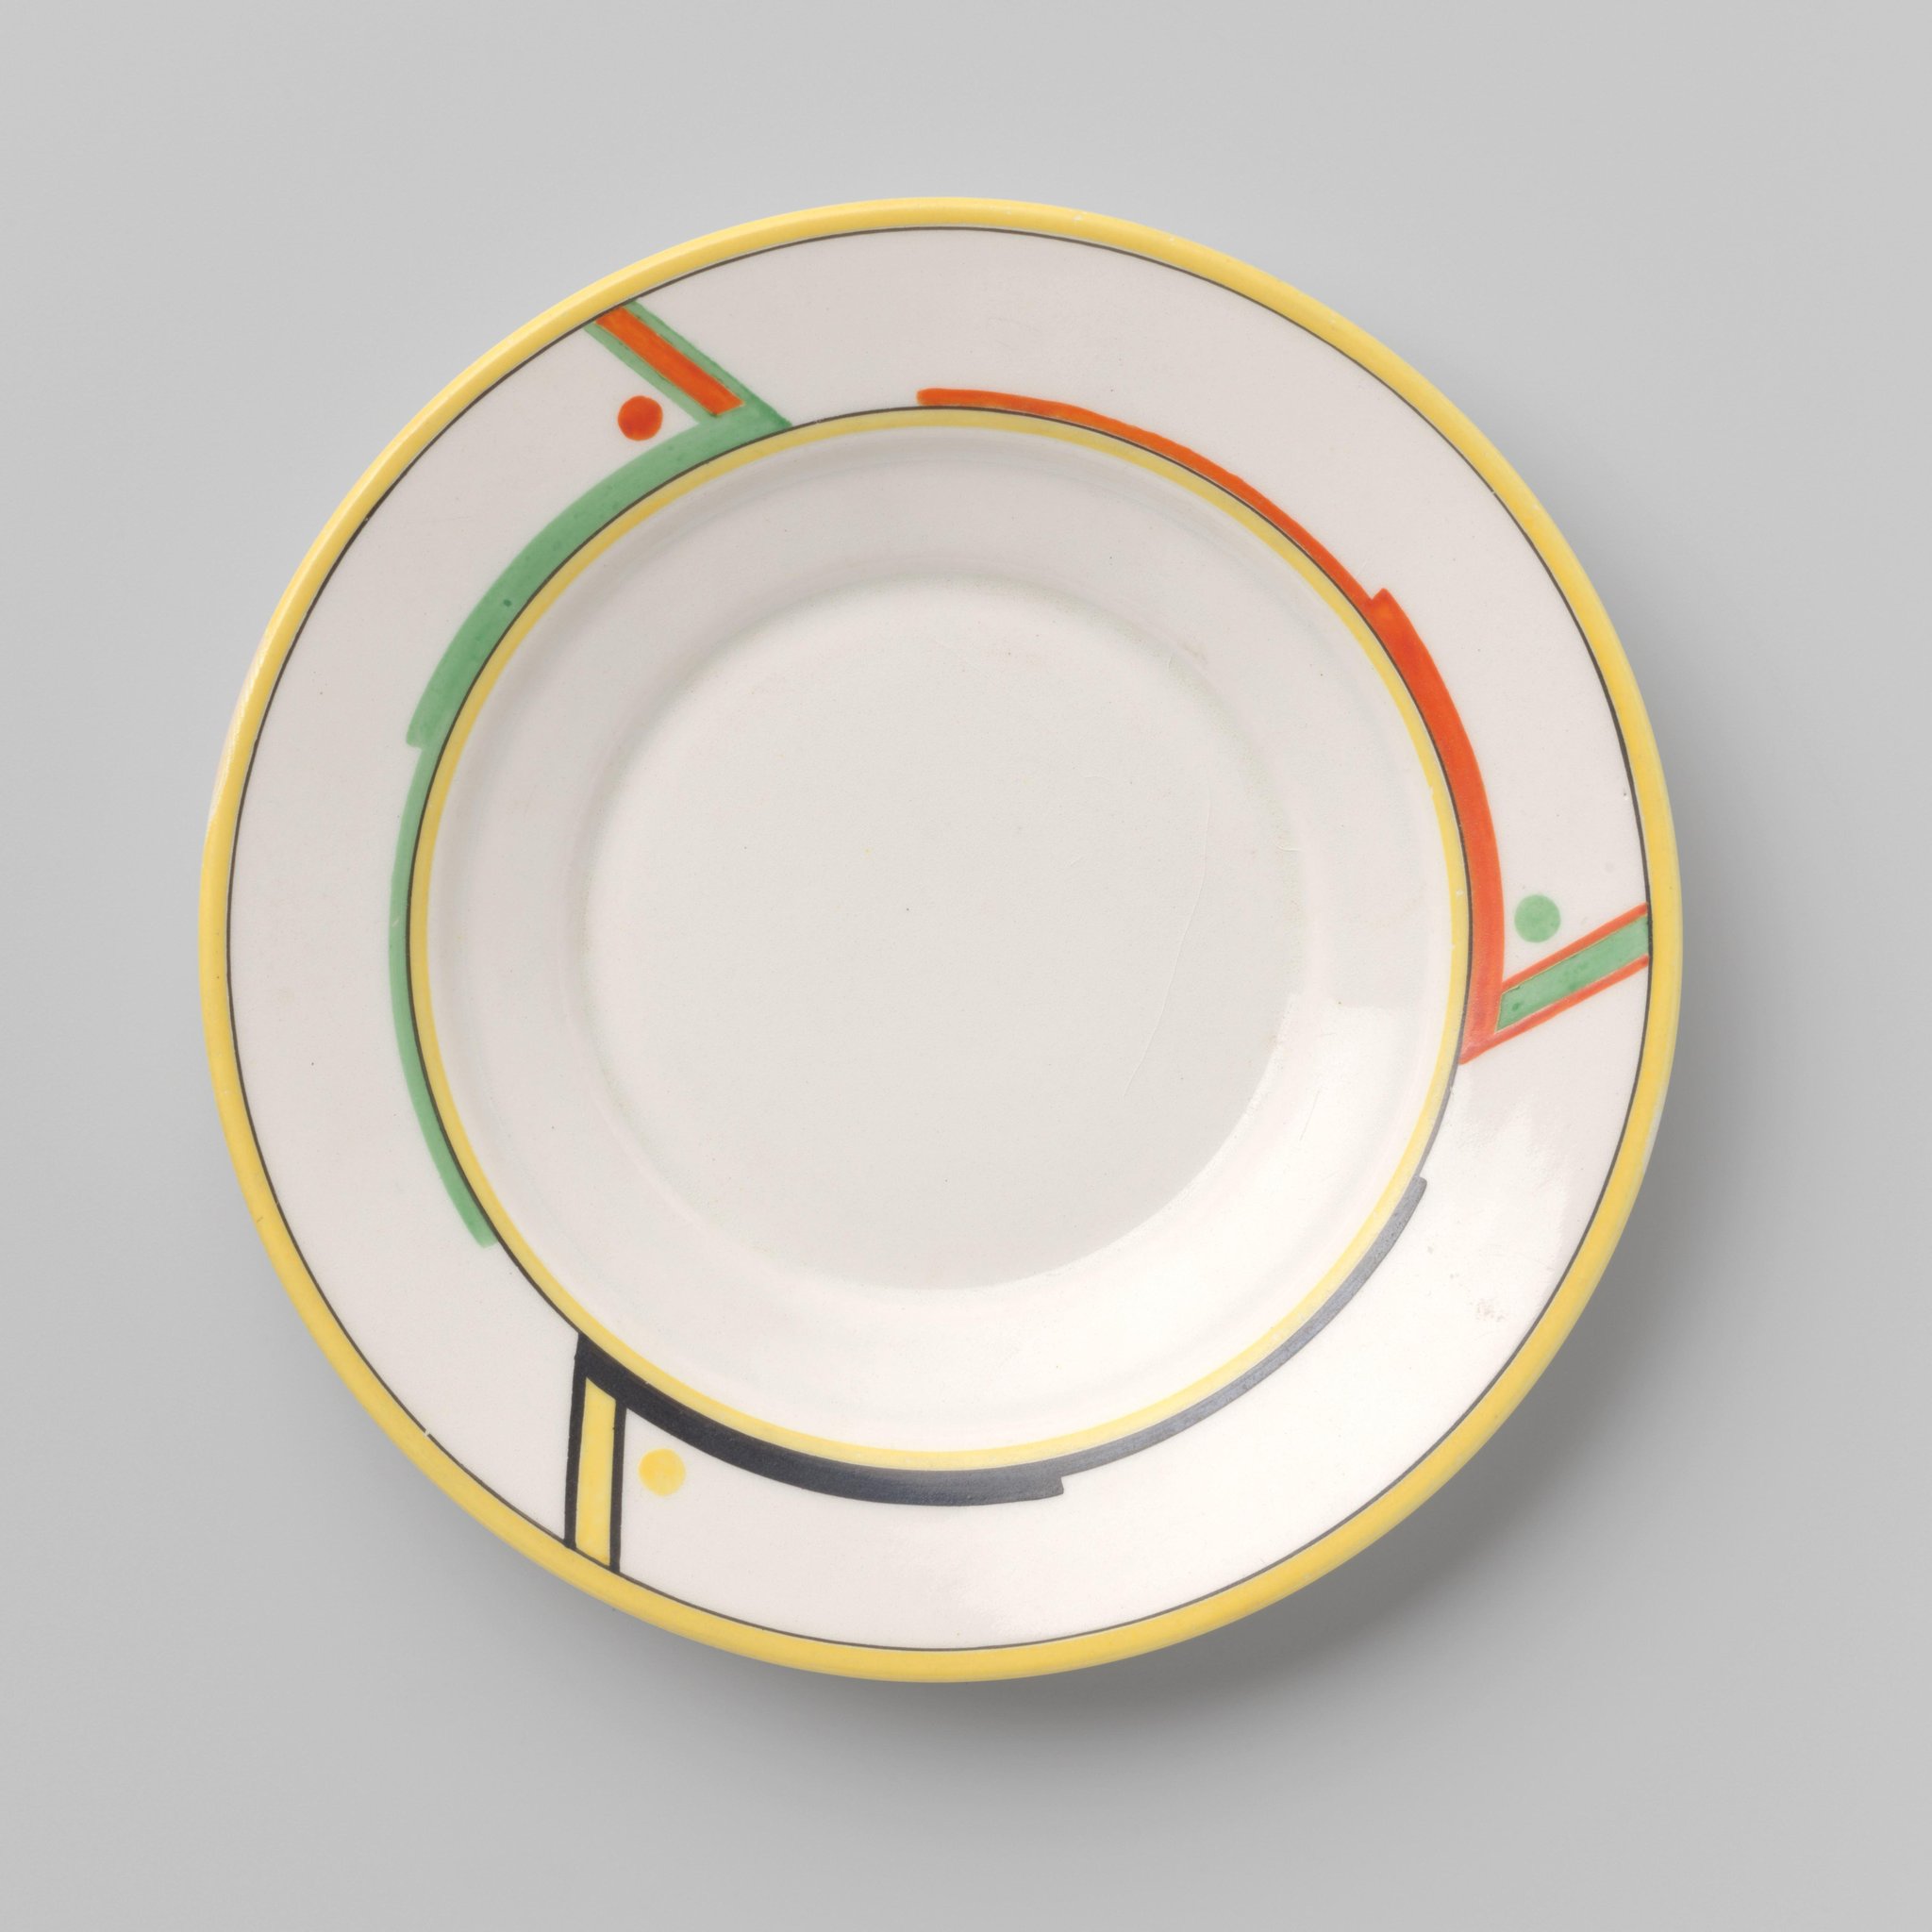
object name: platter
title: Schotel met constructivistisch ornament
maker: chris van der hoef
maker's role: ceramicist, draughtsman, sculptor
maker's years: 1875-1933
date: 1928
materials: earthenware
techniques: painted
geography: gouda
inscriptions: mark: ‘ingestempeld: Plazuid // toren // Gouda ; A7230 (ingegrift)’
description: Schotel van aardewerk, beschilderd in rood, geel, groen en zwart met een constructivistisch ornament. Met bijbehorende kop (A).